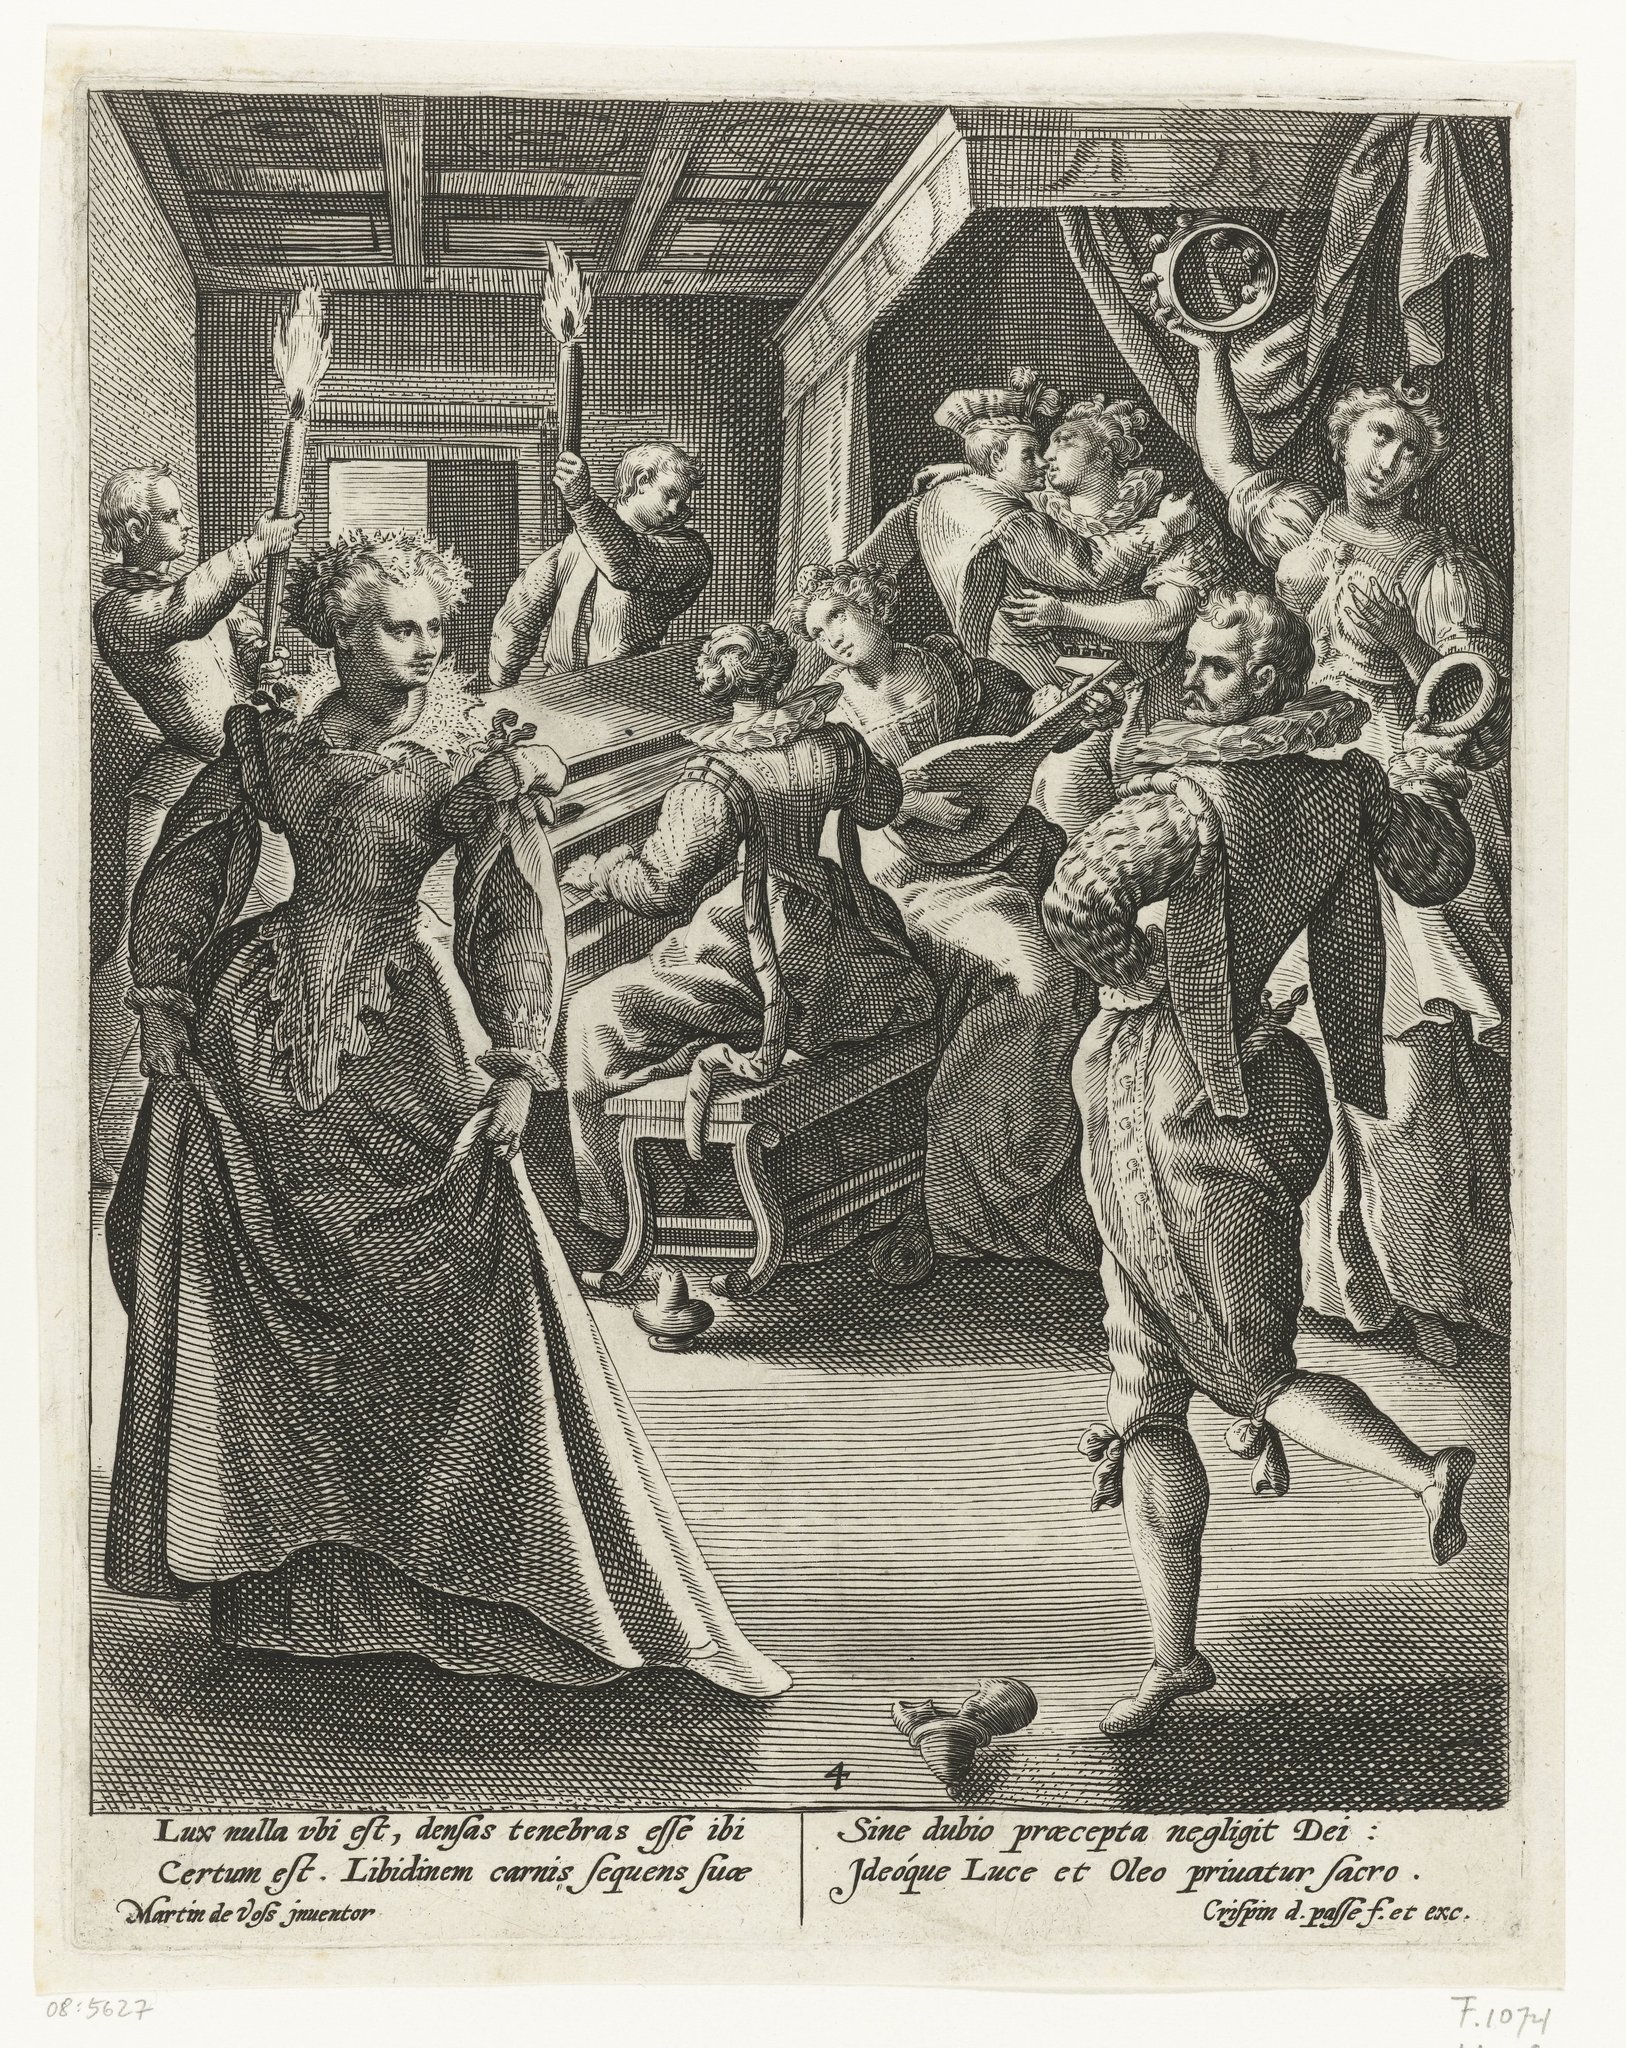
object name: print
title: Parabola V. Virginum Typis Aen: Expressa.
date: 1589-1611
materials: paper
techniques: engraving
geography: cologne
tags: neck-gear ~ clothing (with name) (+ men's clothes), bed with tester, sleeves, one pair dancing; man and woman dancing as a couple, the wise and the foolish virgins ~ parable of christ (matthew 25:1-13), neck-gear: collar (+ women's clothes), dress, gown (+ women's clothes), trousers, breeches, etc. (breeches) (+ men's clothes), sleeves (+ women's clothes), lovers; courting, flirting, more than one musician with instrument, private festivities, merry company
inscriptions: collector's mark: Lugt 2228, collector's mark: Lugt 2161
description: In een vertrek een elegant gezelschap, minnend, musicerend en dansend. De vrouw linksvoor is gekleed in een overkleed met puntlijf* en platte kanten kraag, schouderkleppen* en loshangende siermouwen*. De man rechts draagt eveneens loshangende siermouwen. Kniebroek* gestrikt bij de knie.